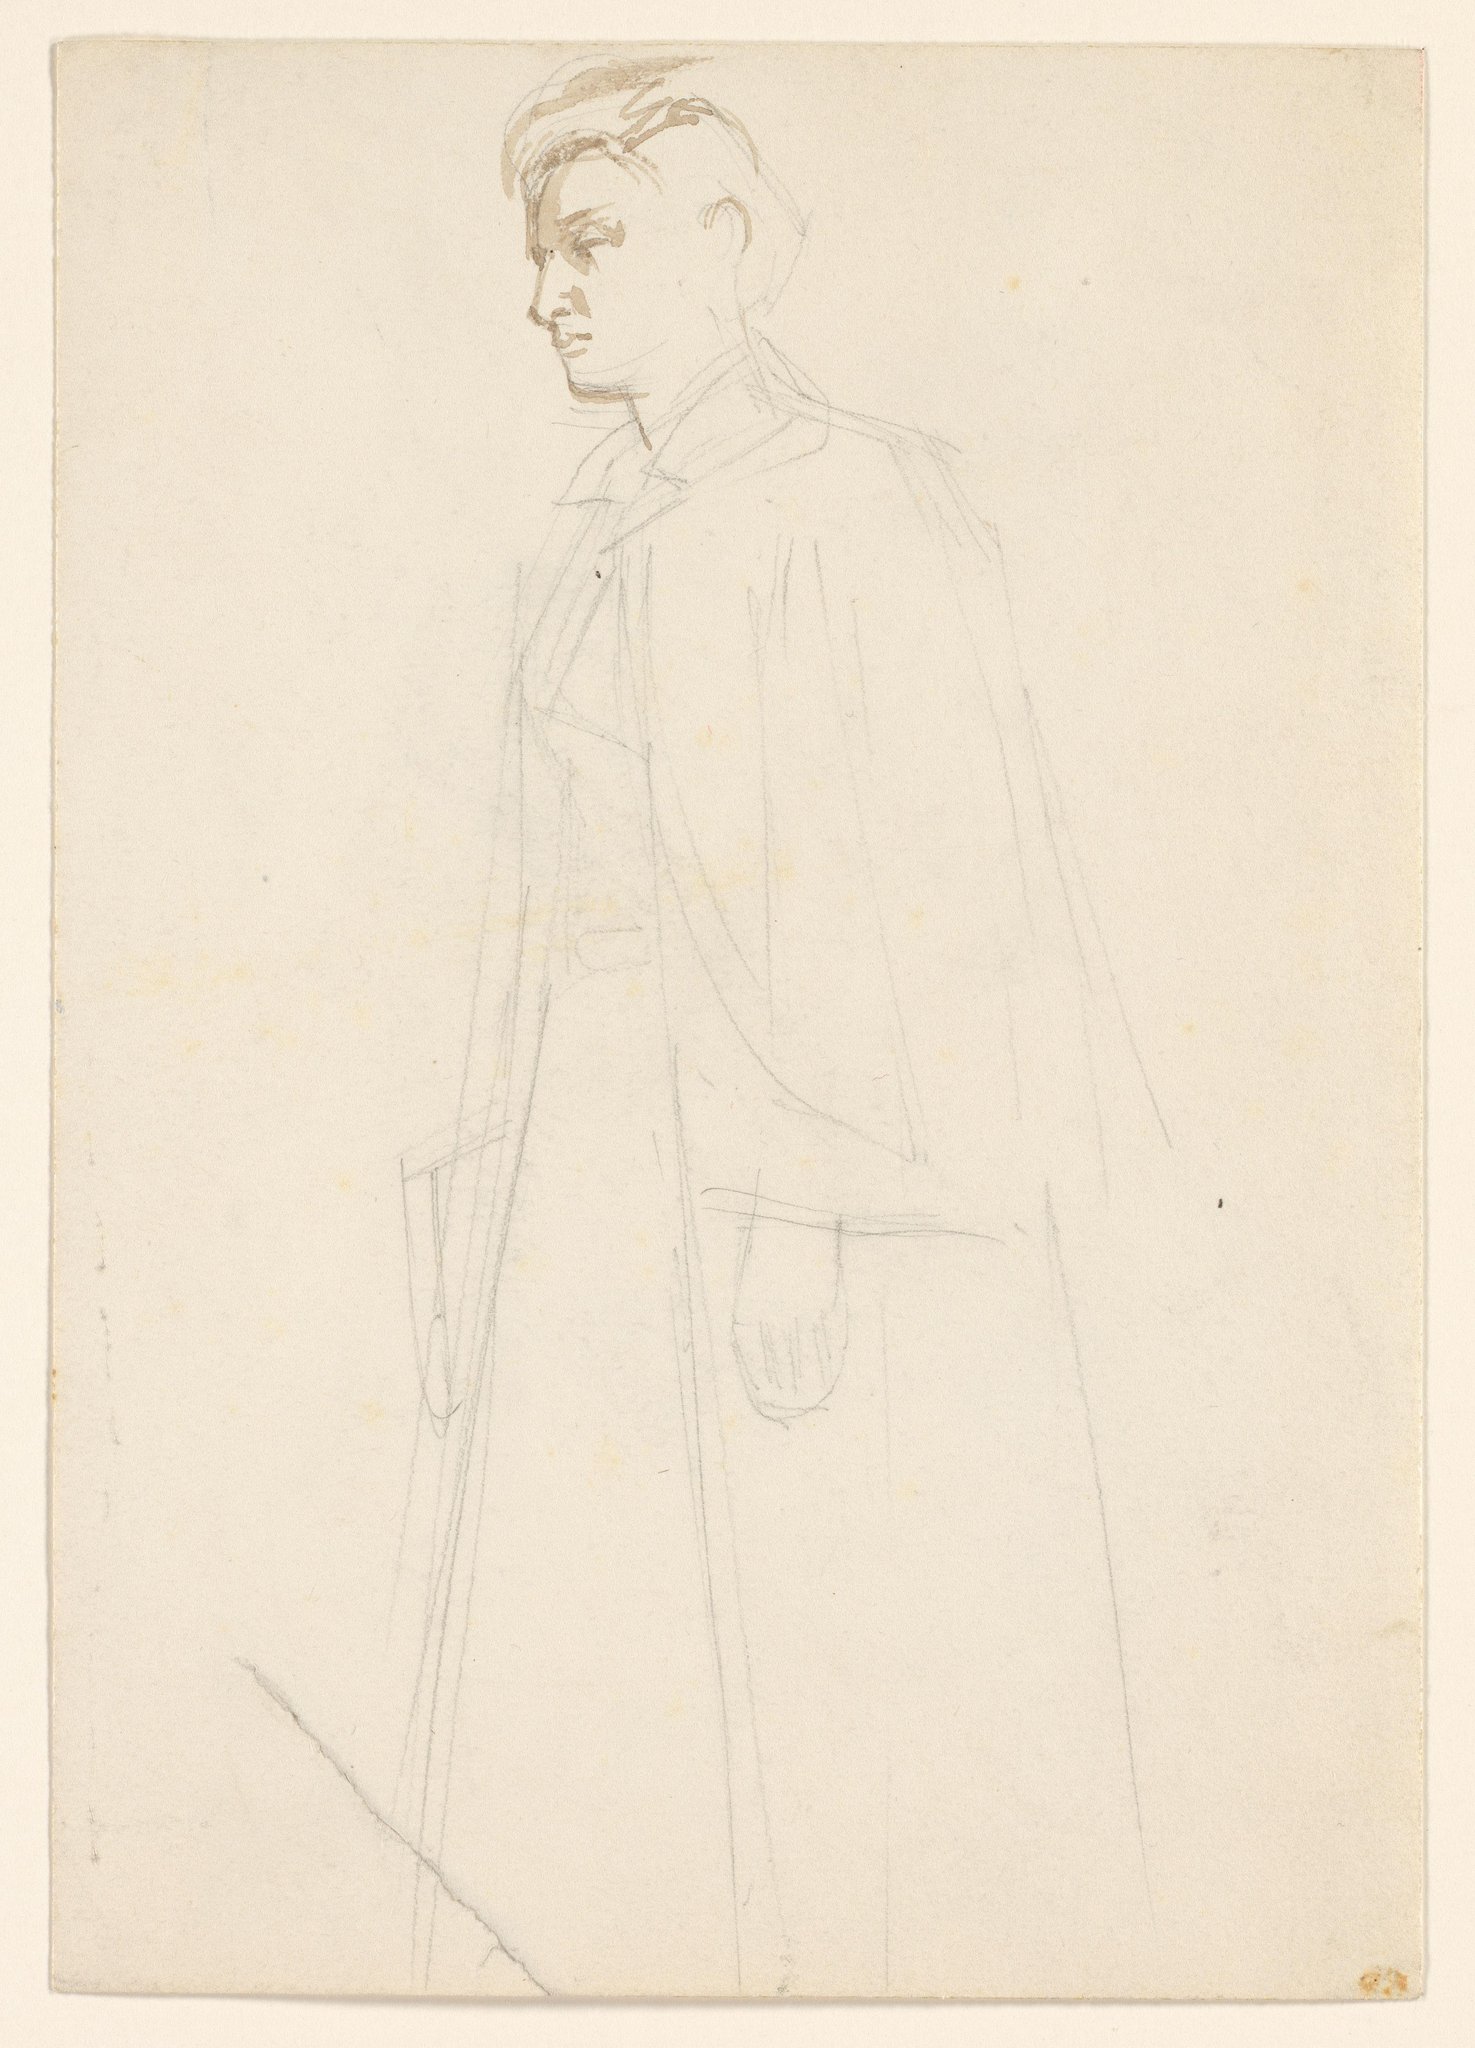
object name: drawing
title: Vrouw met een cape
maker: august allebé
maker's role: draughtsman, print maker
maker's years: 1838-1927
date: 1848-1927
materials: paper, pencil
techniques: brush